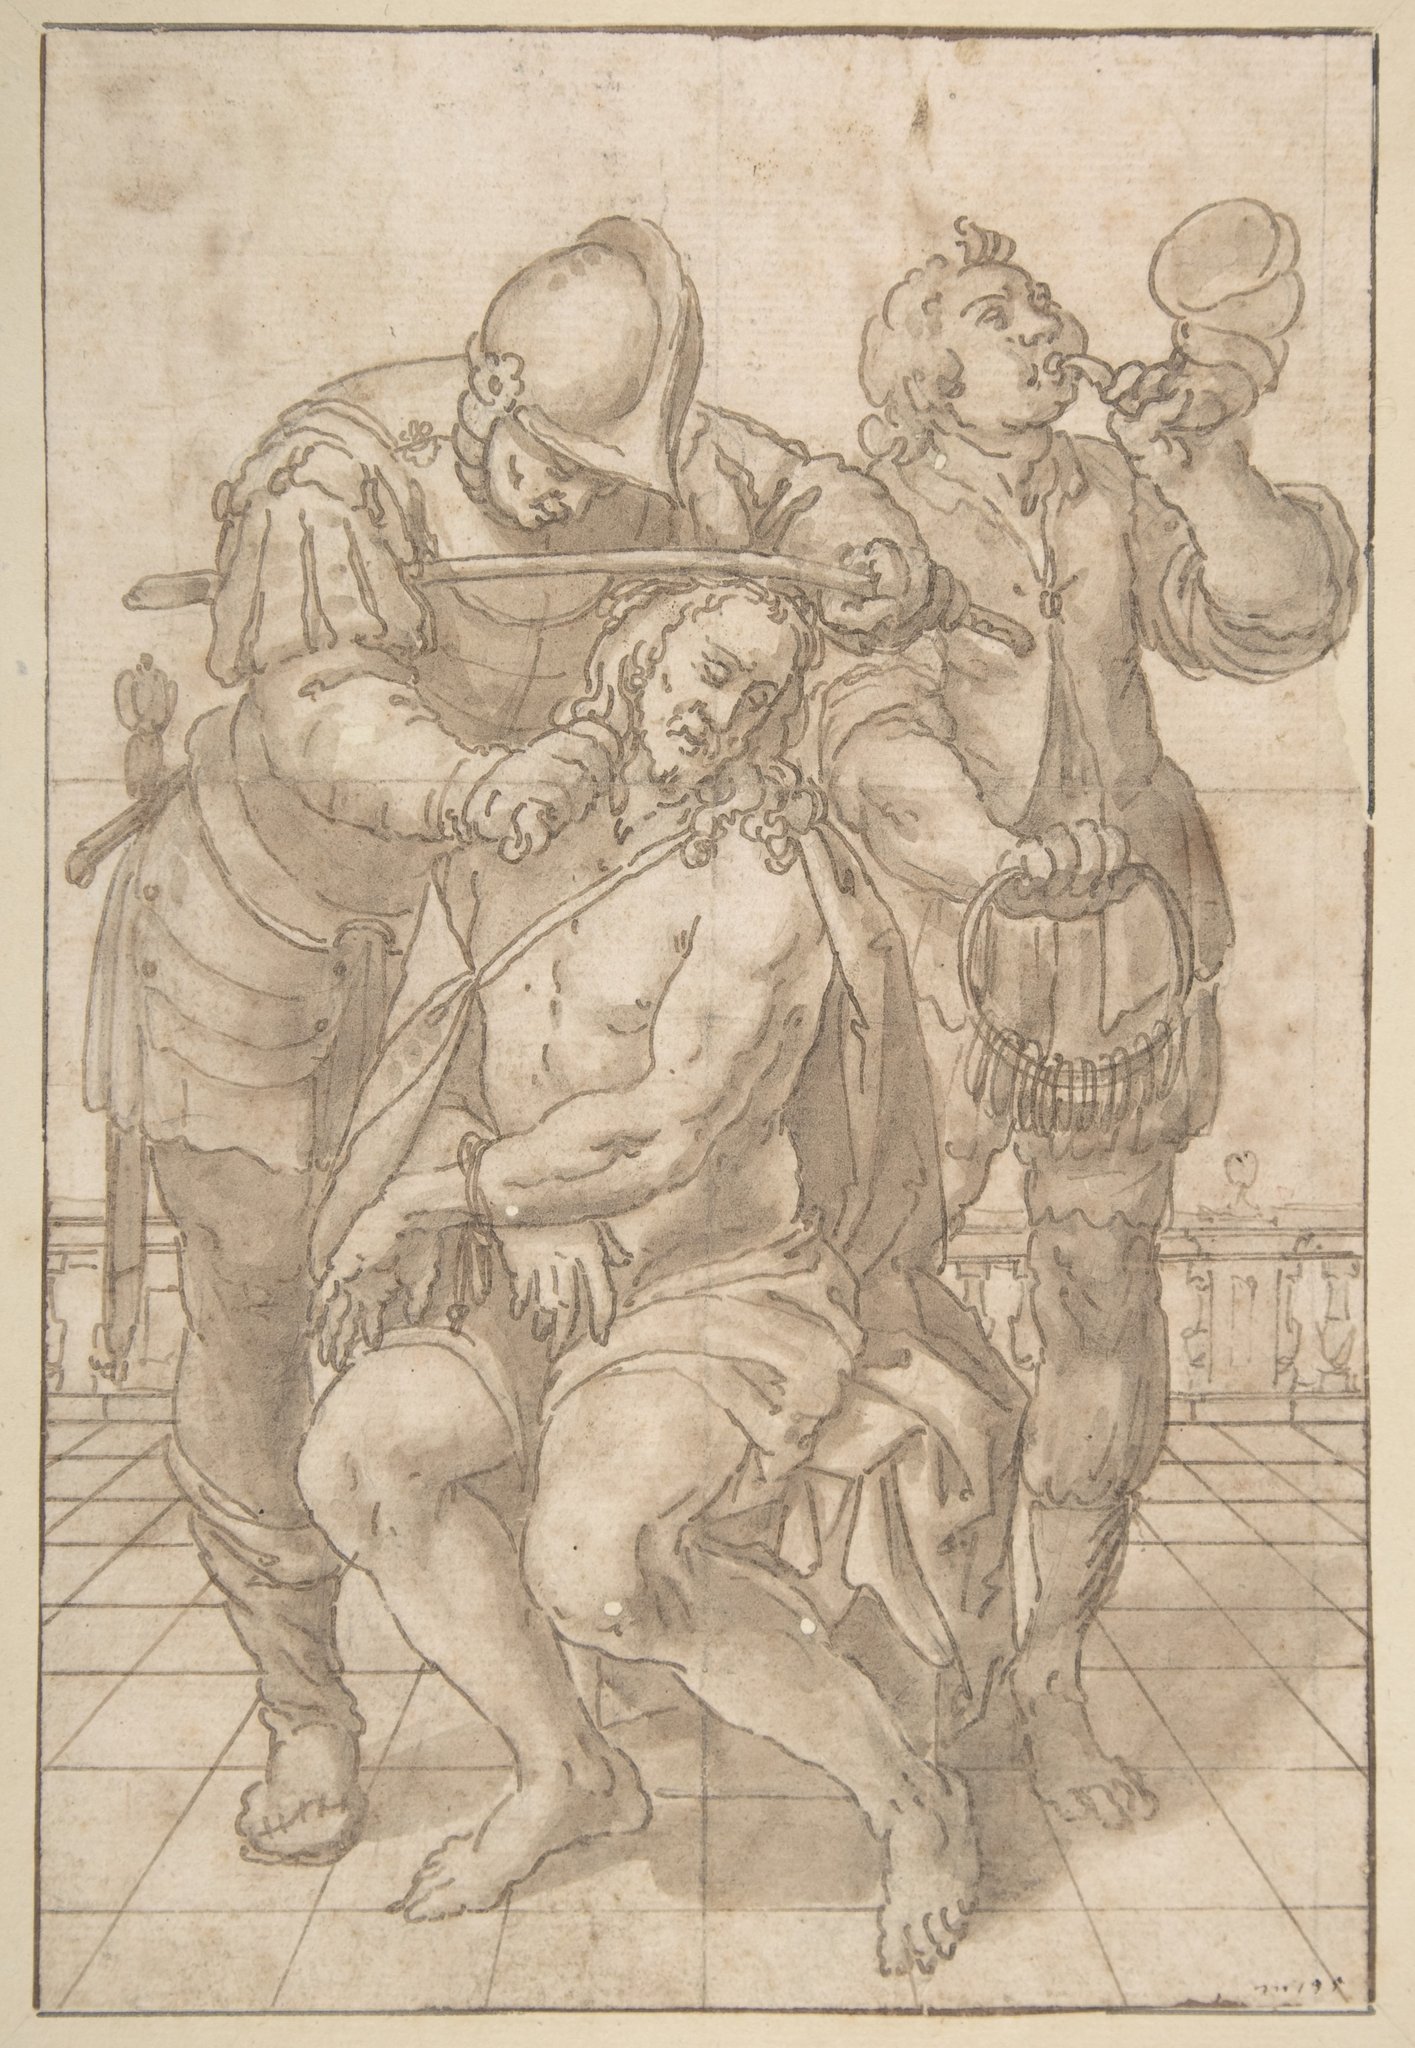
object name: drawing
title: Mocking of Christ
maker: johann heintz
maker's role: artist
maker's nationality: austrian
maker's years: 1580-1635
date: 1567-1633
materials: graphite, ink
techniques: brush, pen, wash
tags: soldiers,men,christ